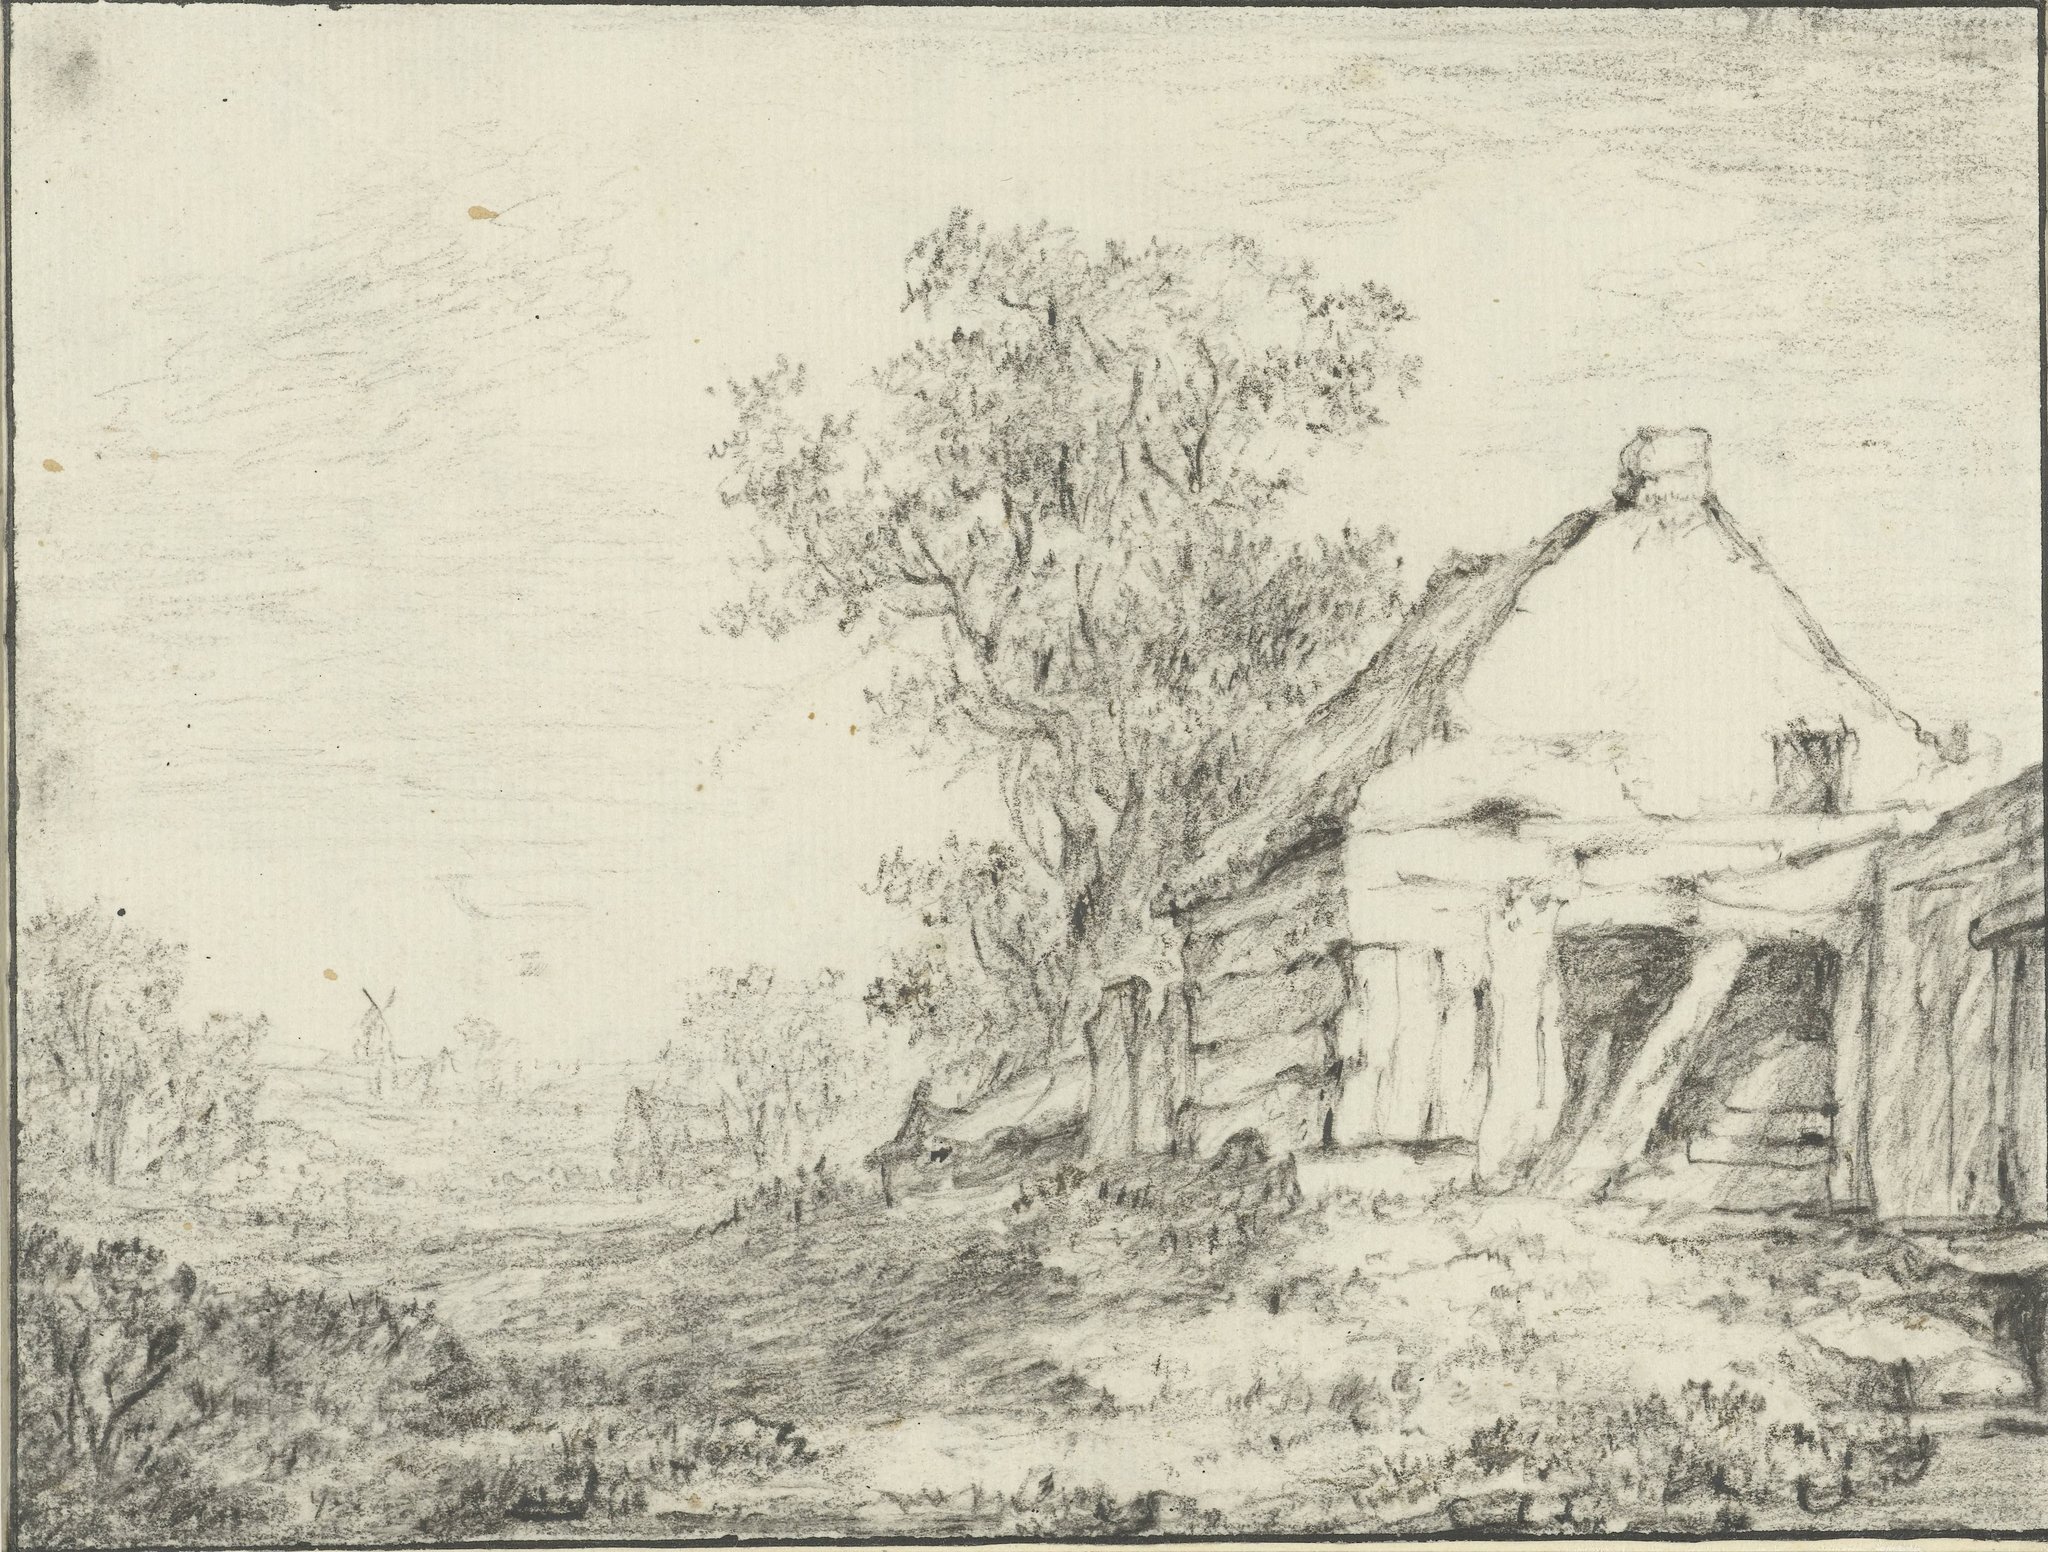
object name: drawing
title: Vervallen schuur bij een boom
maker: jacob van der smissen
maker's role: draughtsman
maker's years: 1735-1813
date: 1745-1813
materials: chalk, paper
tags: farm (building)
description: Vervallen schuur bij een boom; in de verte een molen.